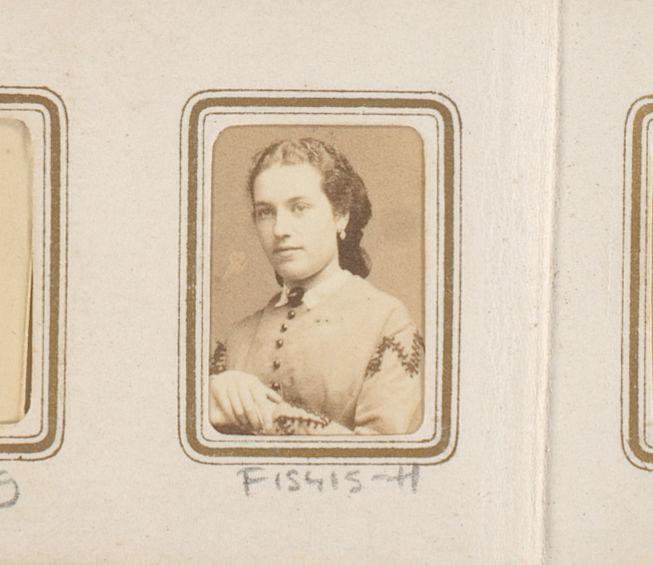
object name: photograph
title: Miniatuurportet van een onbekende man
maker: Anonymous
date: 1851-1870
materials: paper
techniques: albumen print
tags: adult man, anonymous historical person portrayed